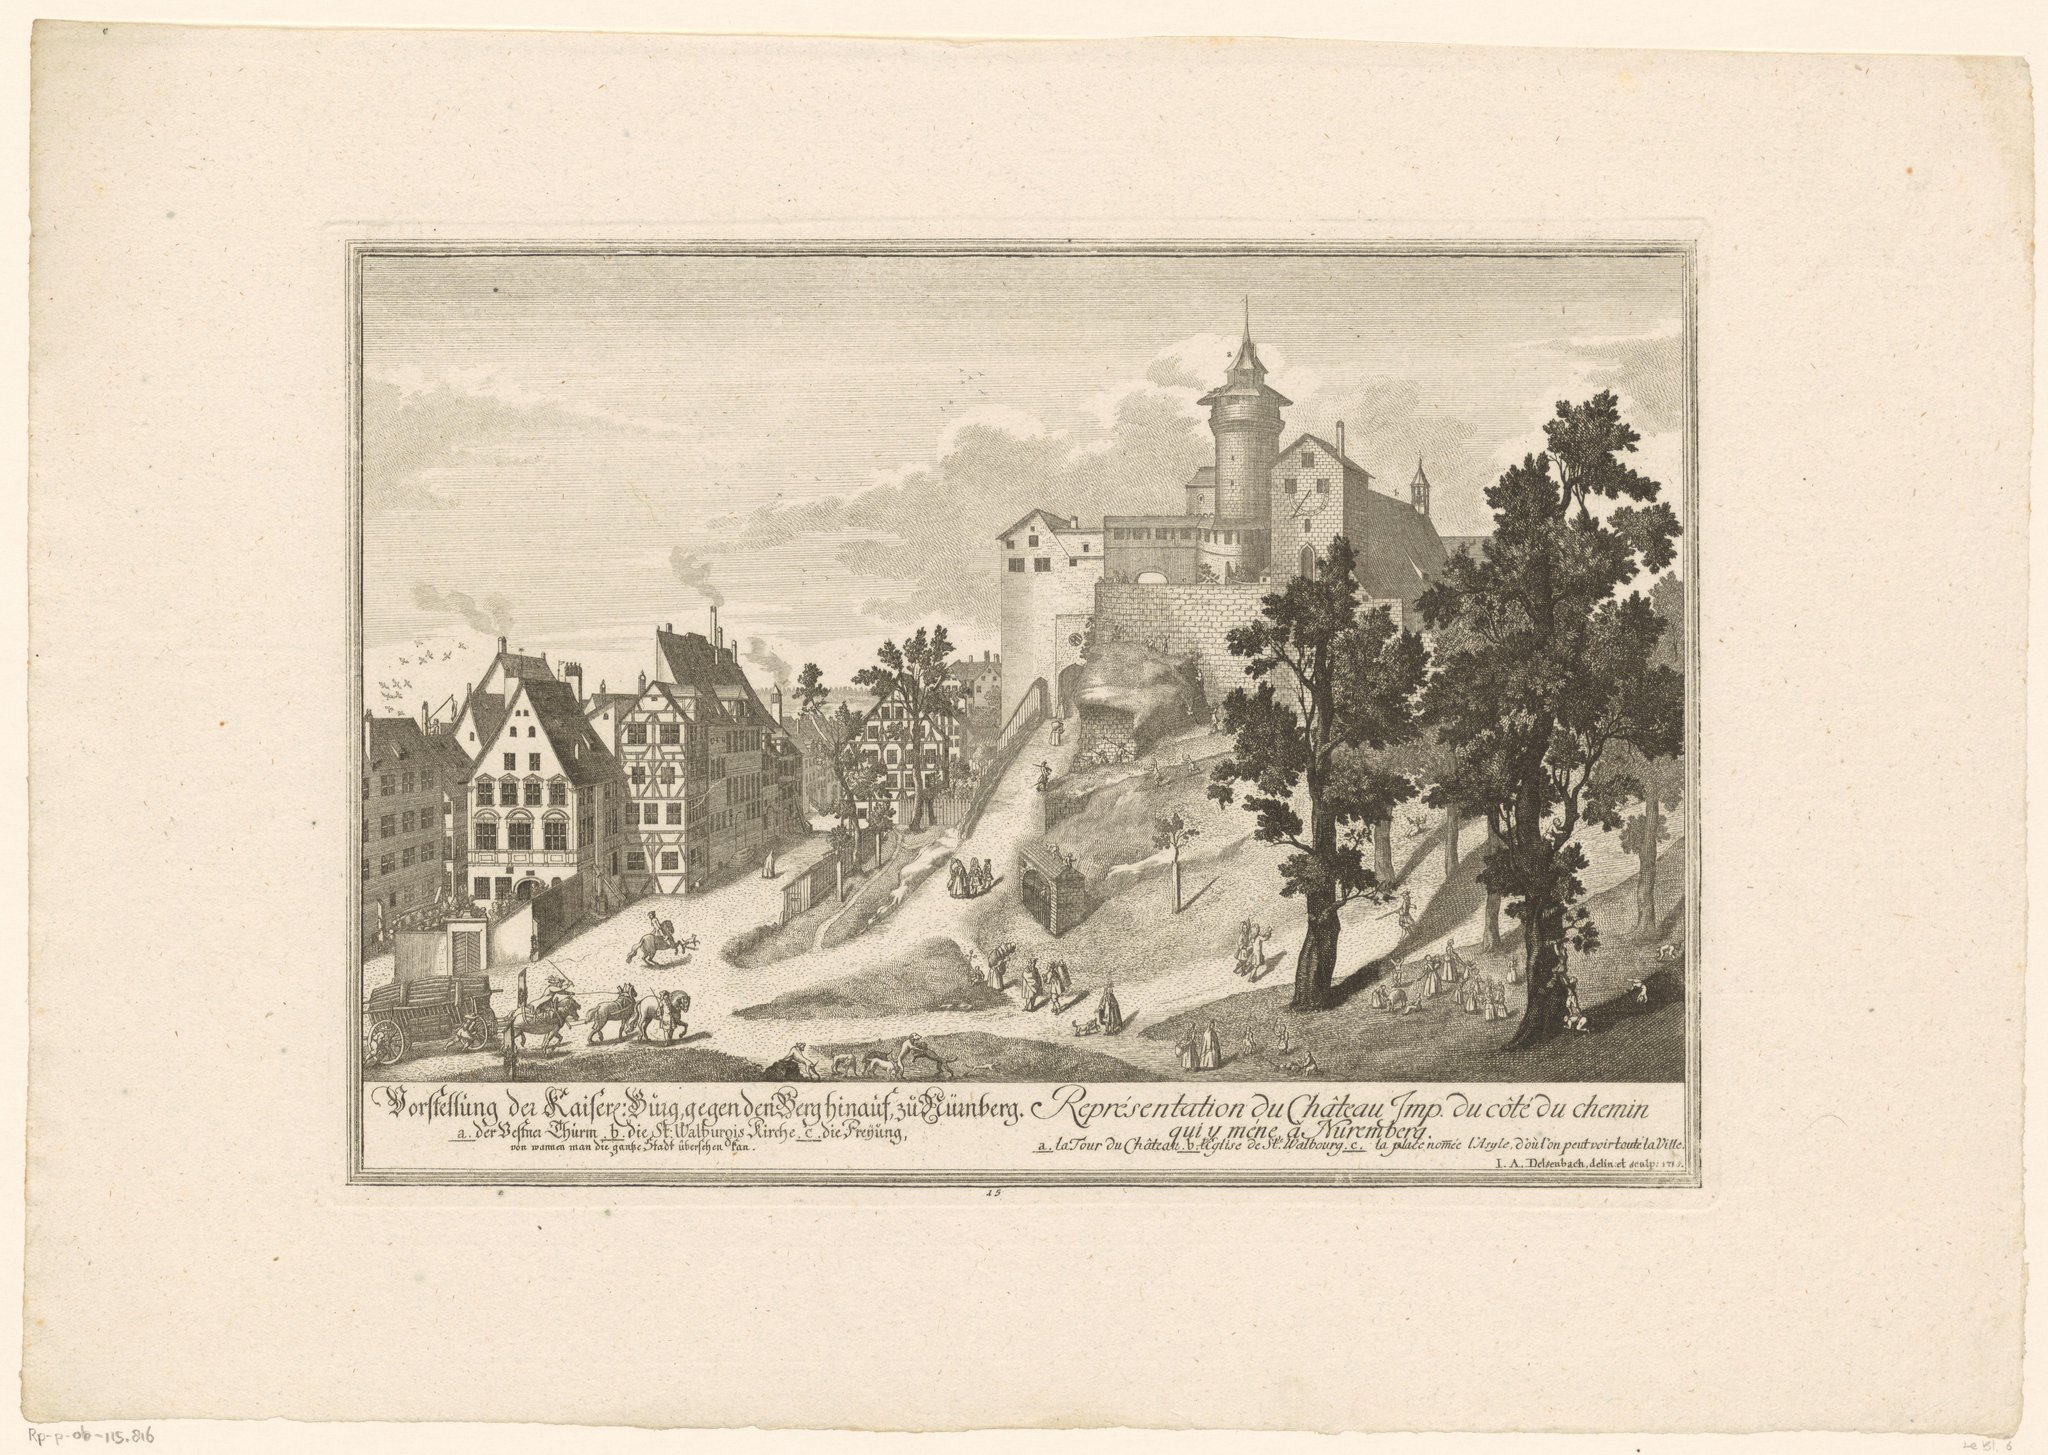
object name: print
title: Stadsgezichten van Neurenberg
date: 1716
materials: paper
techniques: etching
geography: nuremberg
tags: city-view in general; 'veduta', bourgeoisie, middle class, citizens, burghers, fortified house in city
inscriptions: collector's mark: Lugt 2228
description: Deze prent behoort tot een serie van Neurenbergse stadsgezichten. Het Rijksmuseum heeft zestien prenten uit deze reeks in bezit, waarvan de laatste is voorzien van nummer 24. Het is onduidelijk uit hoeveel prenten de originele serie bestaat.